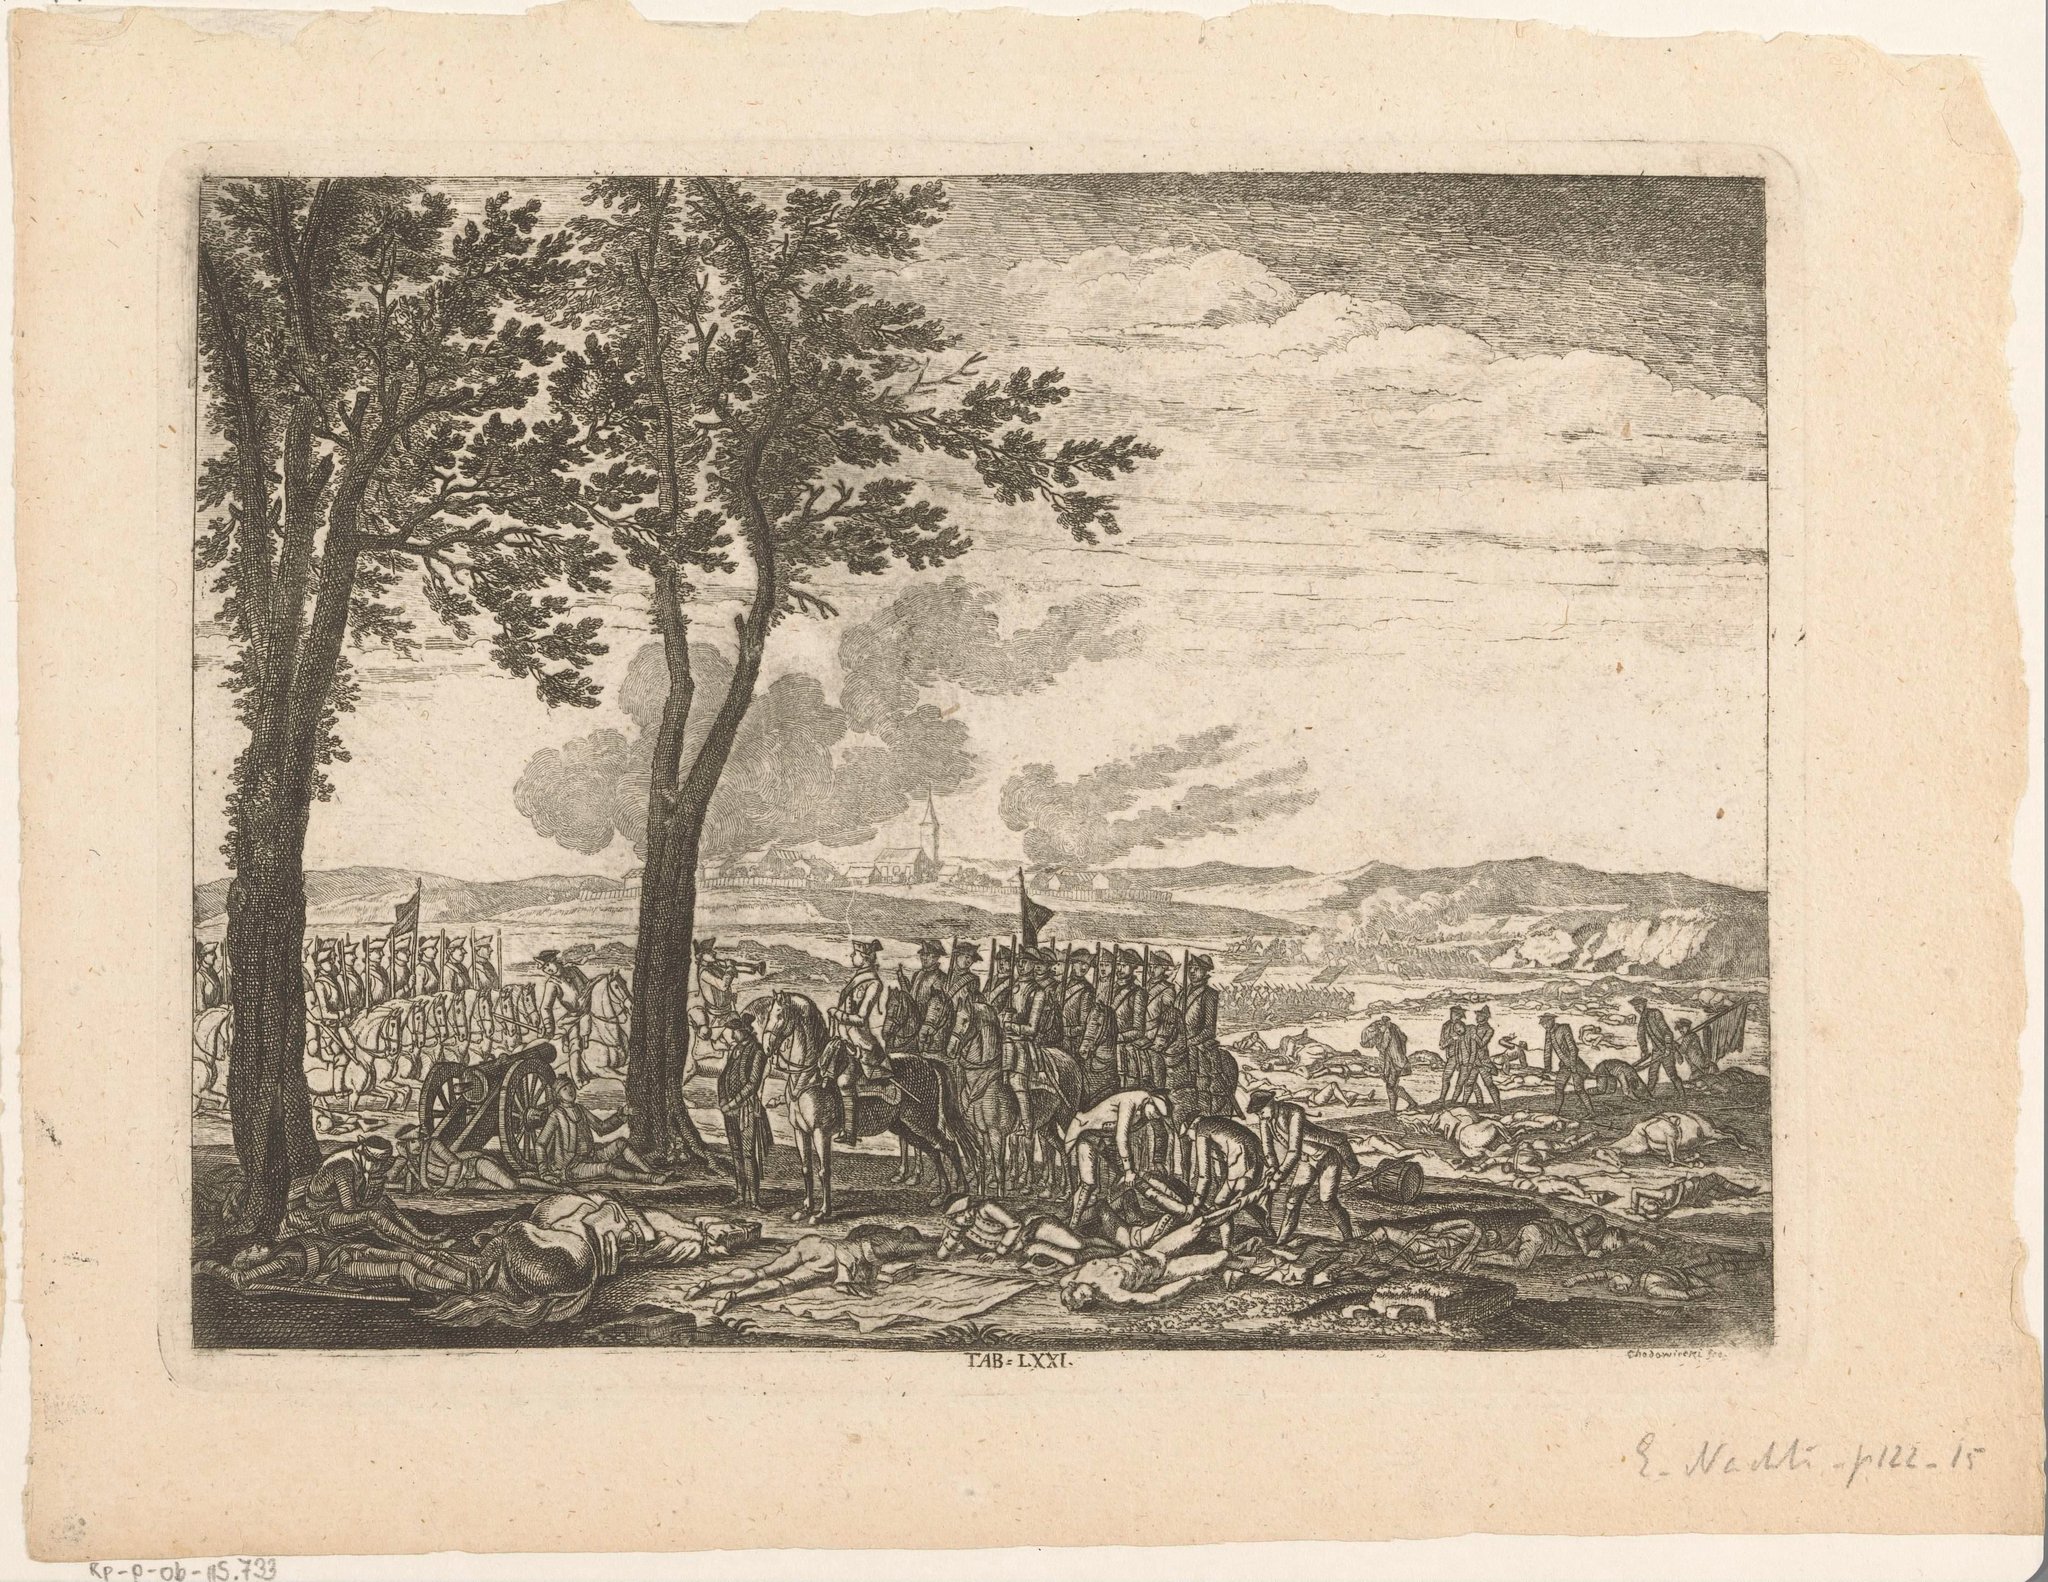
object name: print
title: Soldaten na de strijd op het slagveld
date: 1774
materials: paper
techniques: etching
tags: landscapes, carrying the sick, wounded and dead off the battle-field, after the battle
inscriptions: collector's mark: Lugt 2228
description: Prent uit: Basedow, Johann Bernhard. Kupfersammlung zu J.B. Basedows Elementarwerke für die Jugend und ihre Freunde (...). Berlijn en Dessau: s.n., 1774.